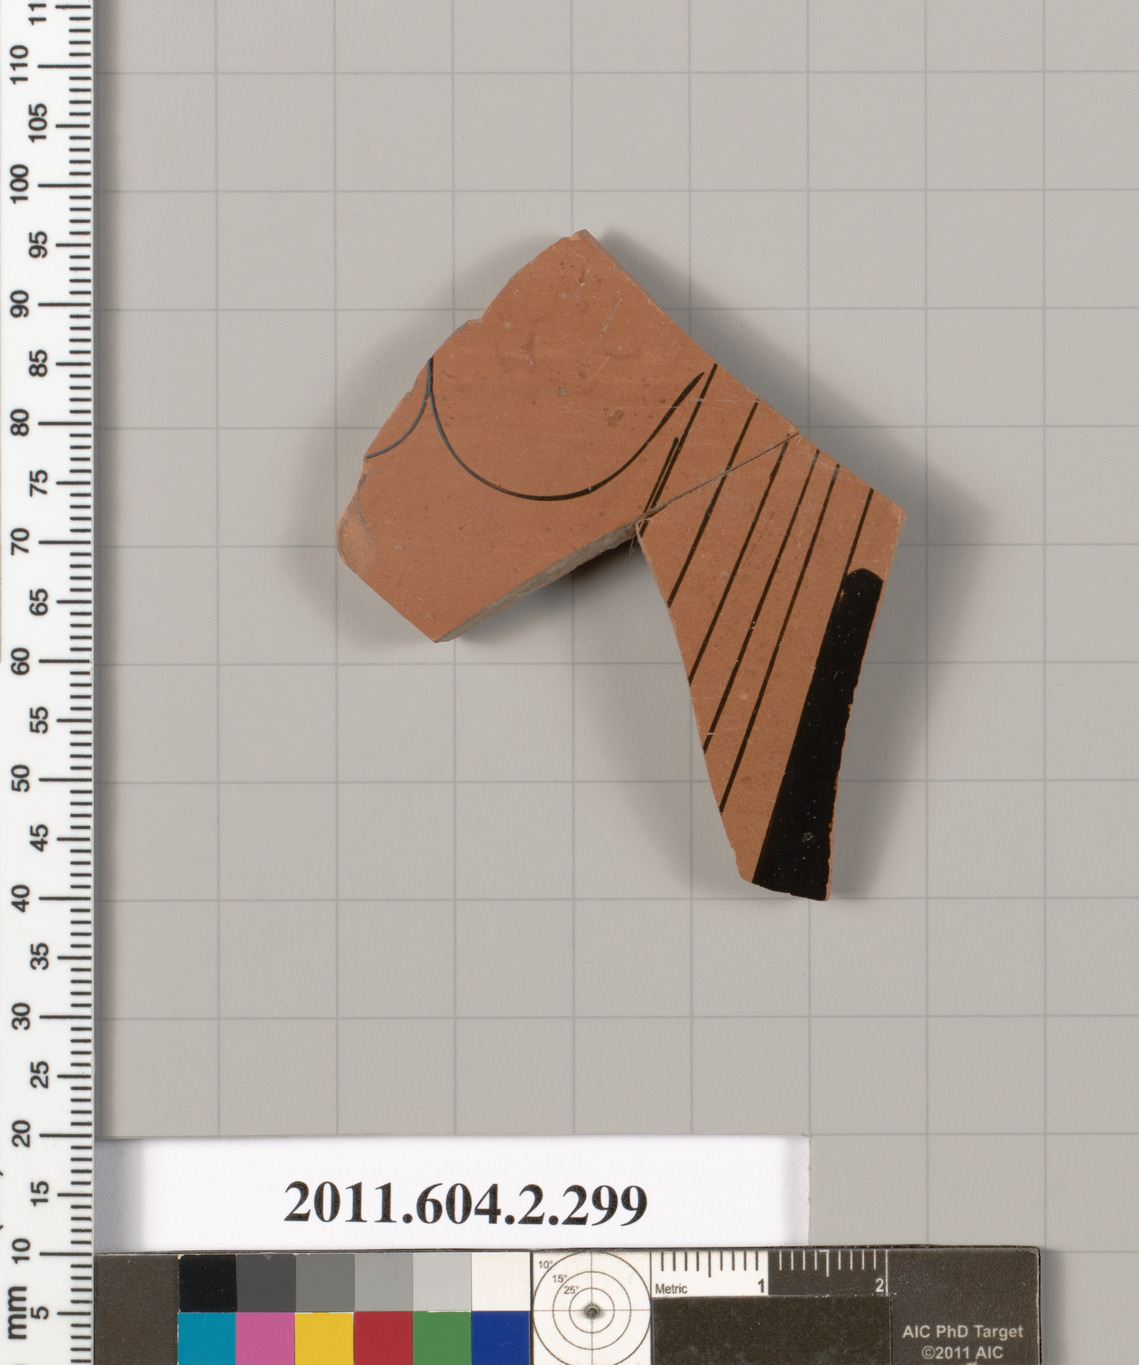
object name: column krater fragment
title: Terracotta fragment of a column-krater (bowl for mixing wine and water)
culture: greek, attic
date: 475-451 BCE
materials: terracotta